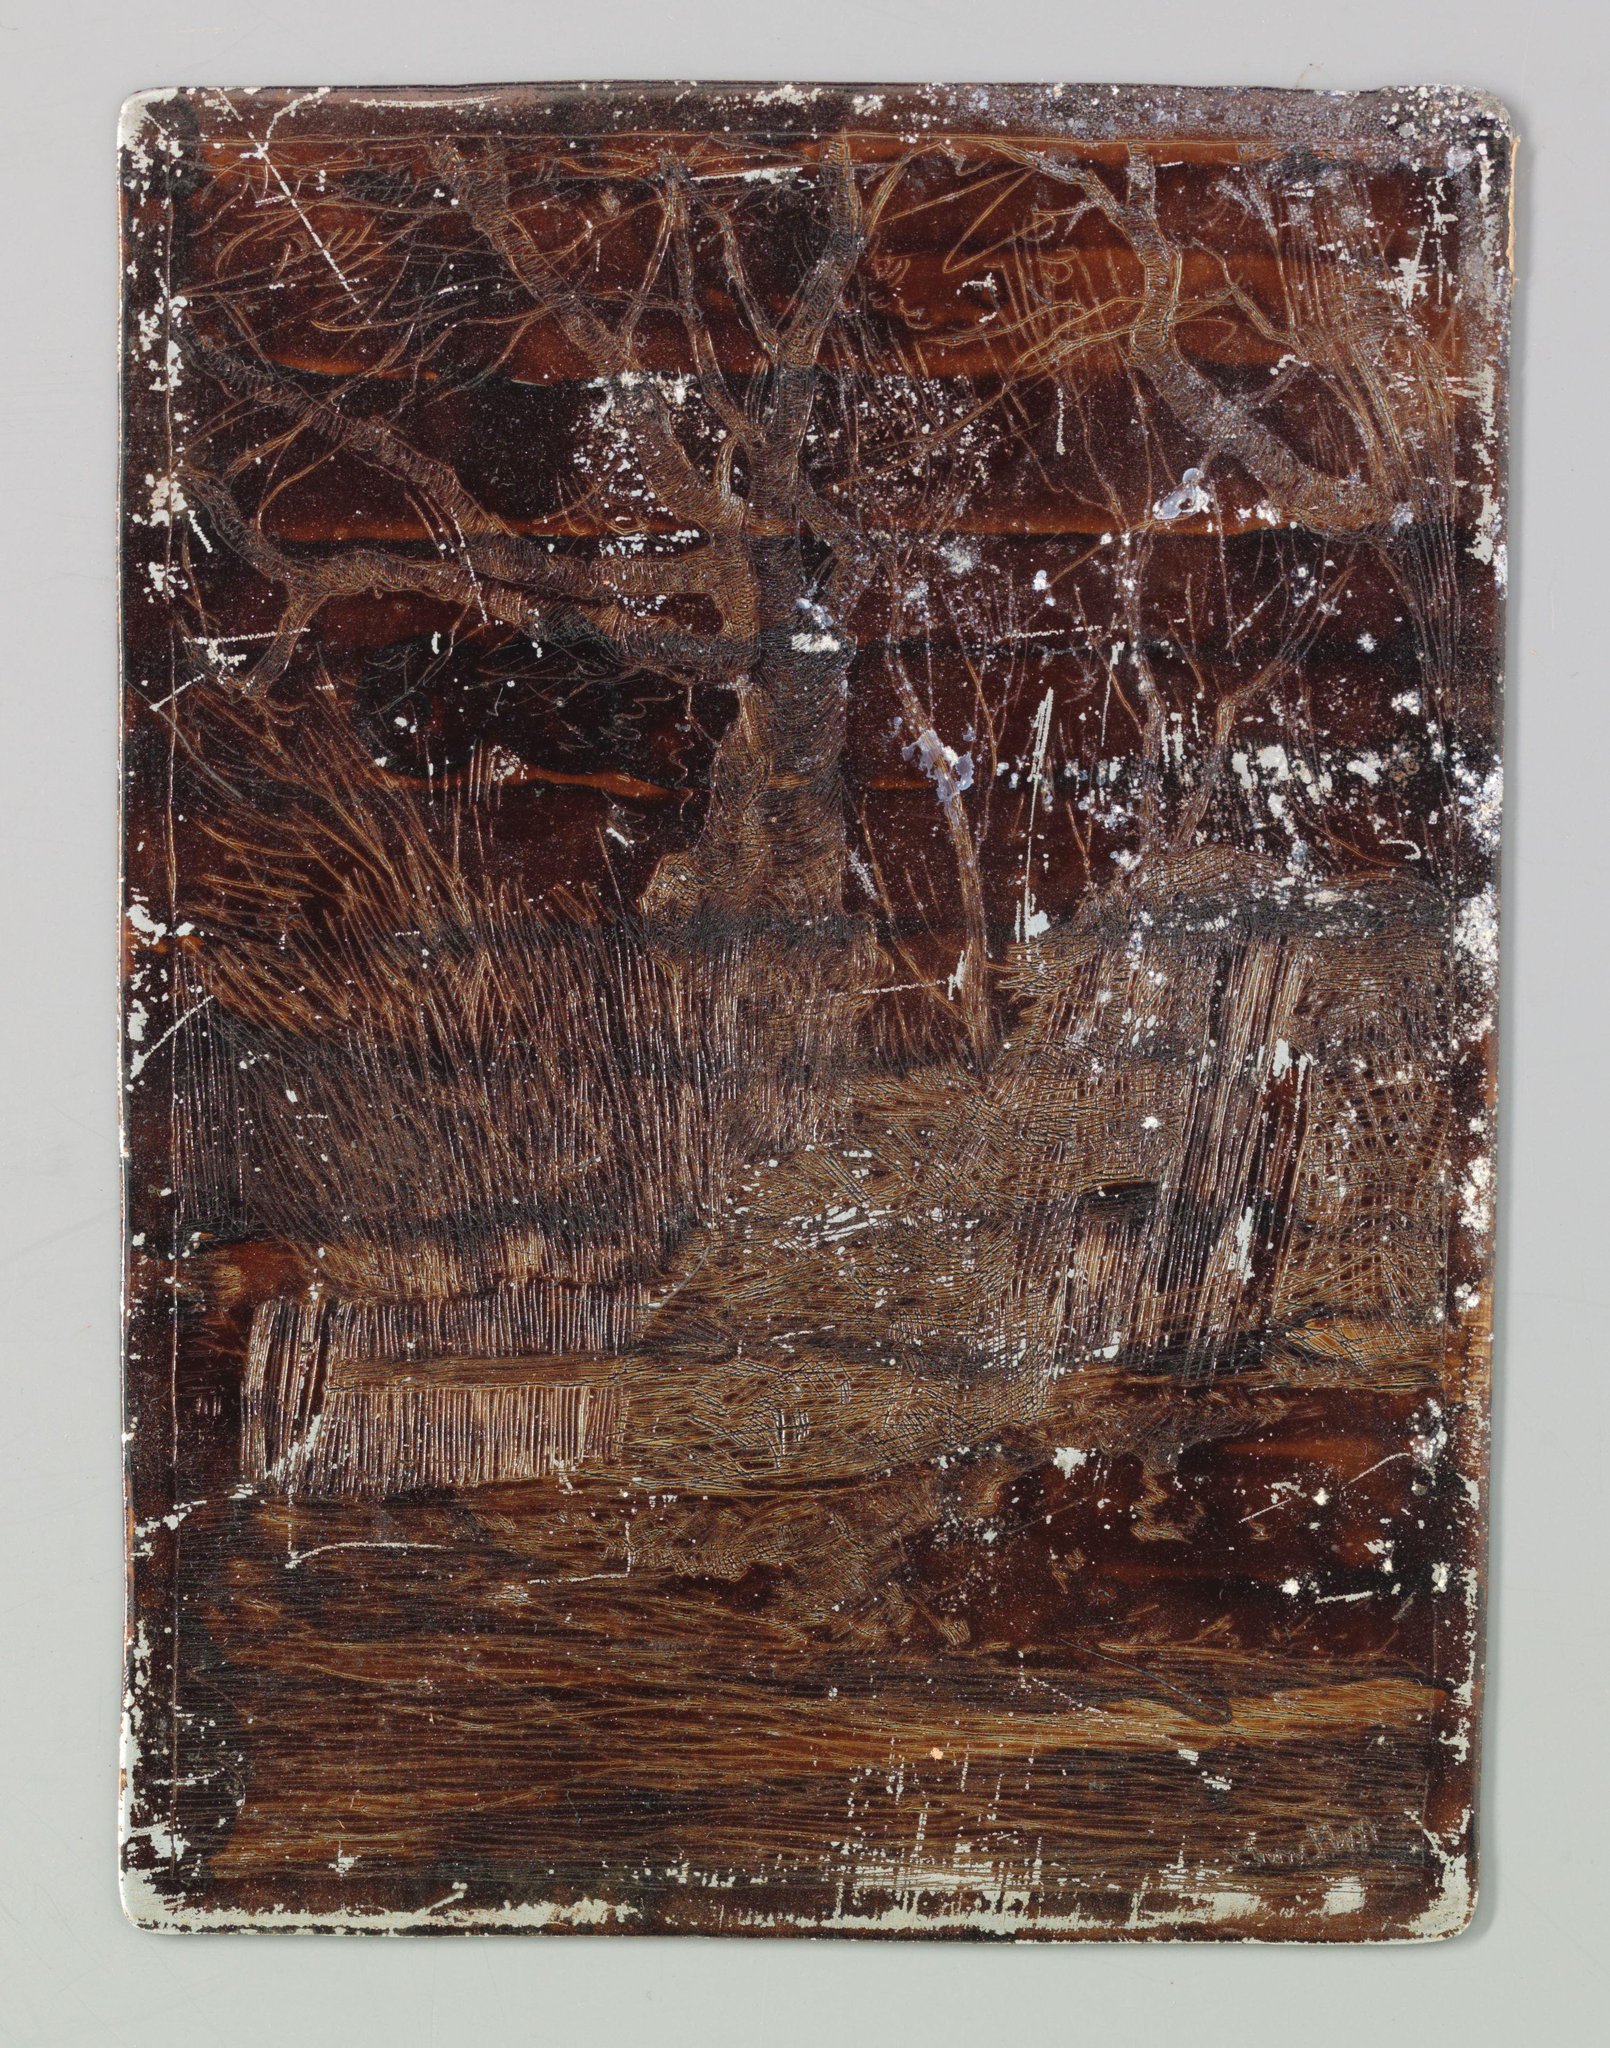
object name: zinkplaat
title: Takkenbos bij heining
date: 1889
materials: zinc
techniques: etching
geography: netherlands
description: Etsplaat van zink voor de ets 'Takkenbos bij een omheining van bomen'. ca. 1889-'90.